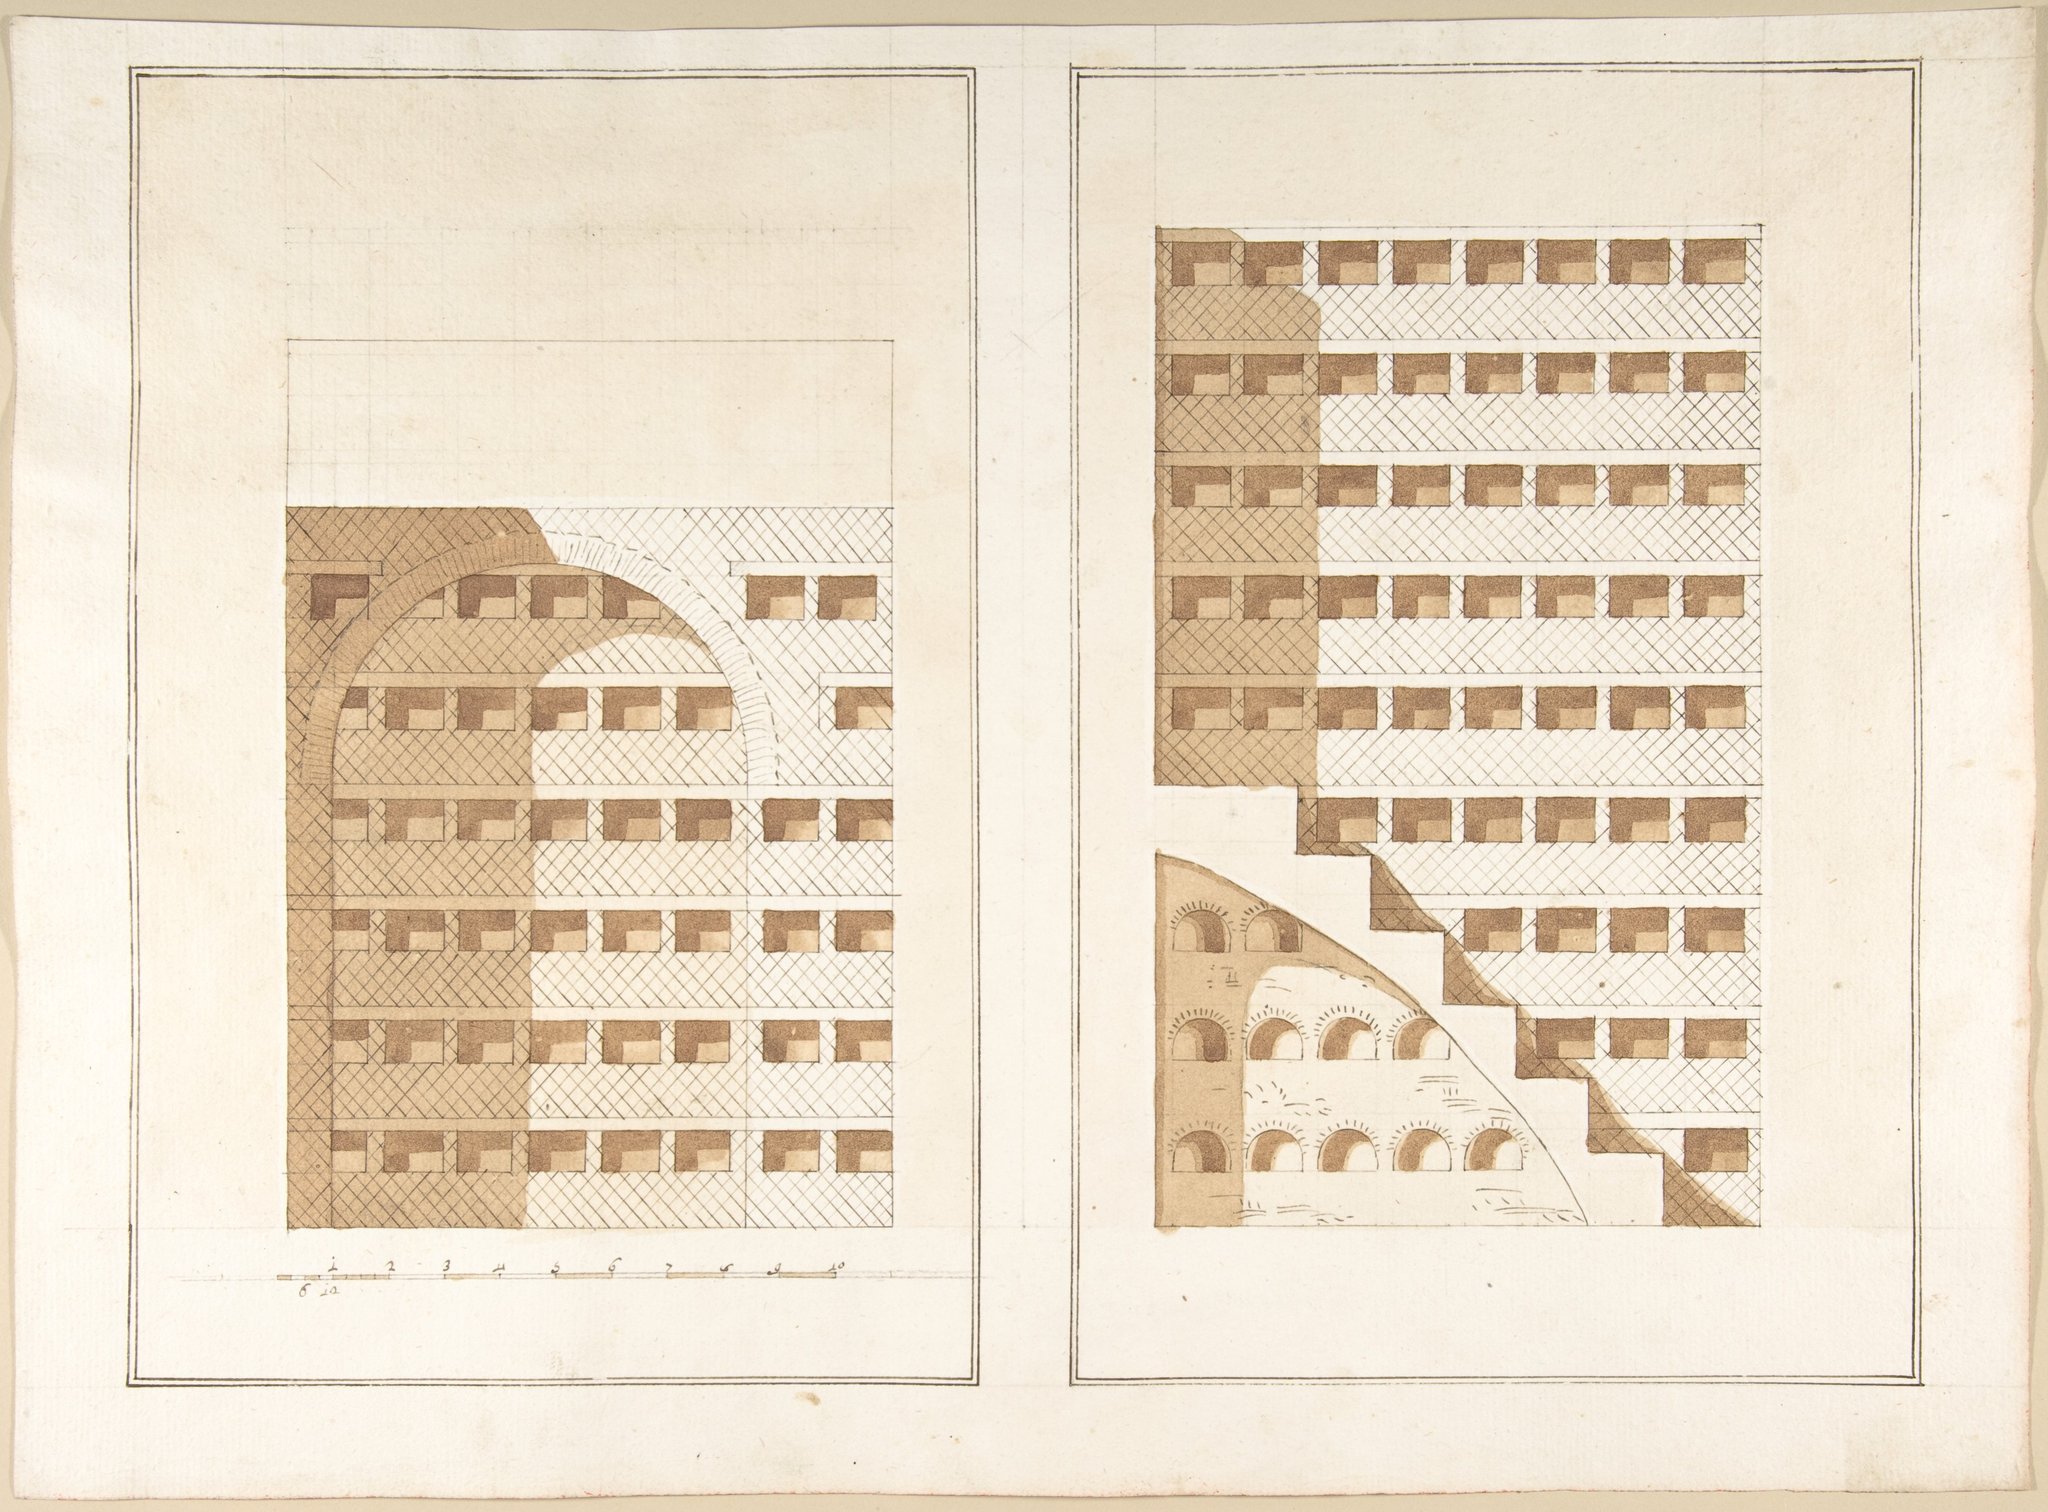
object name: drawing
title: Two Sections of a Columbarium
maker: pietro paolo coccetti (cocchetti)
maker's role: artist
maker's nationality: italian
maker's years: 1710-1727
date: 1710-1727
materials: graphite, ink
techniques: brush, pen, wash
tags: architecture,buildings